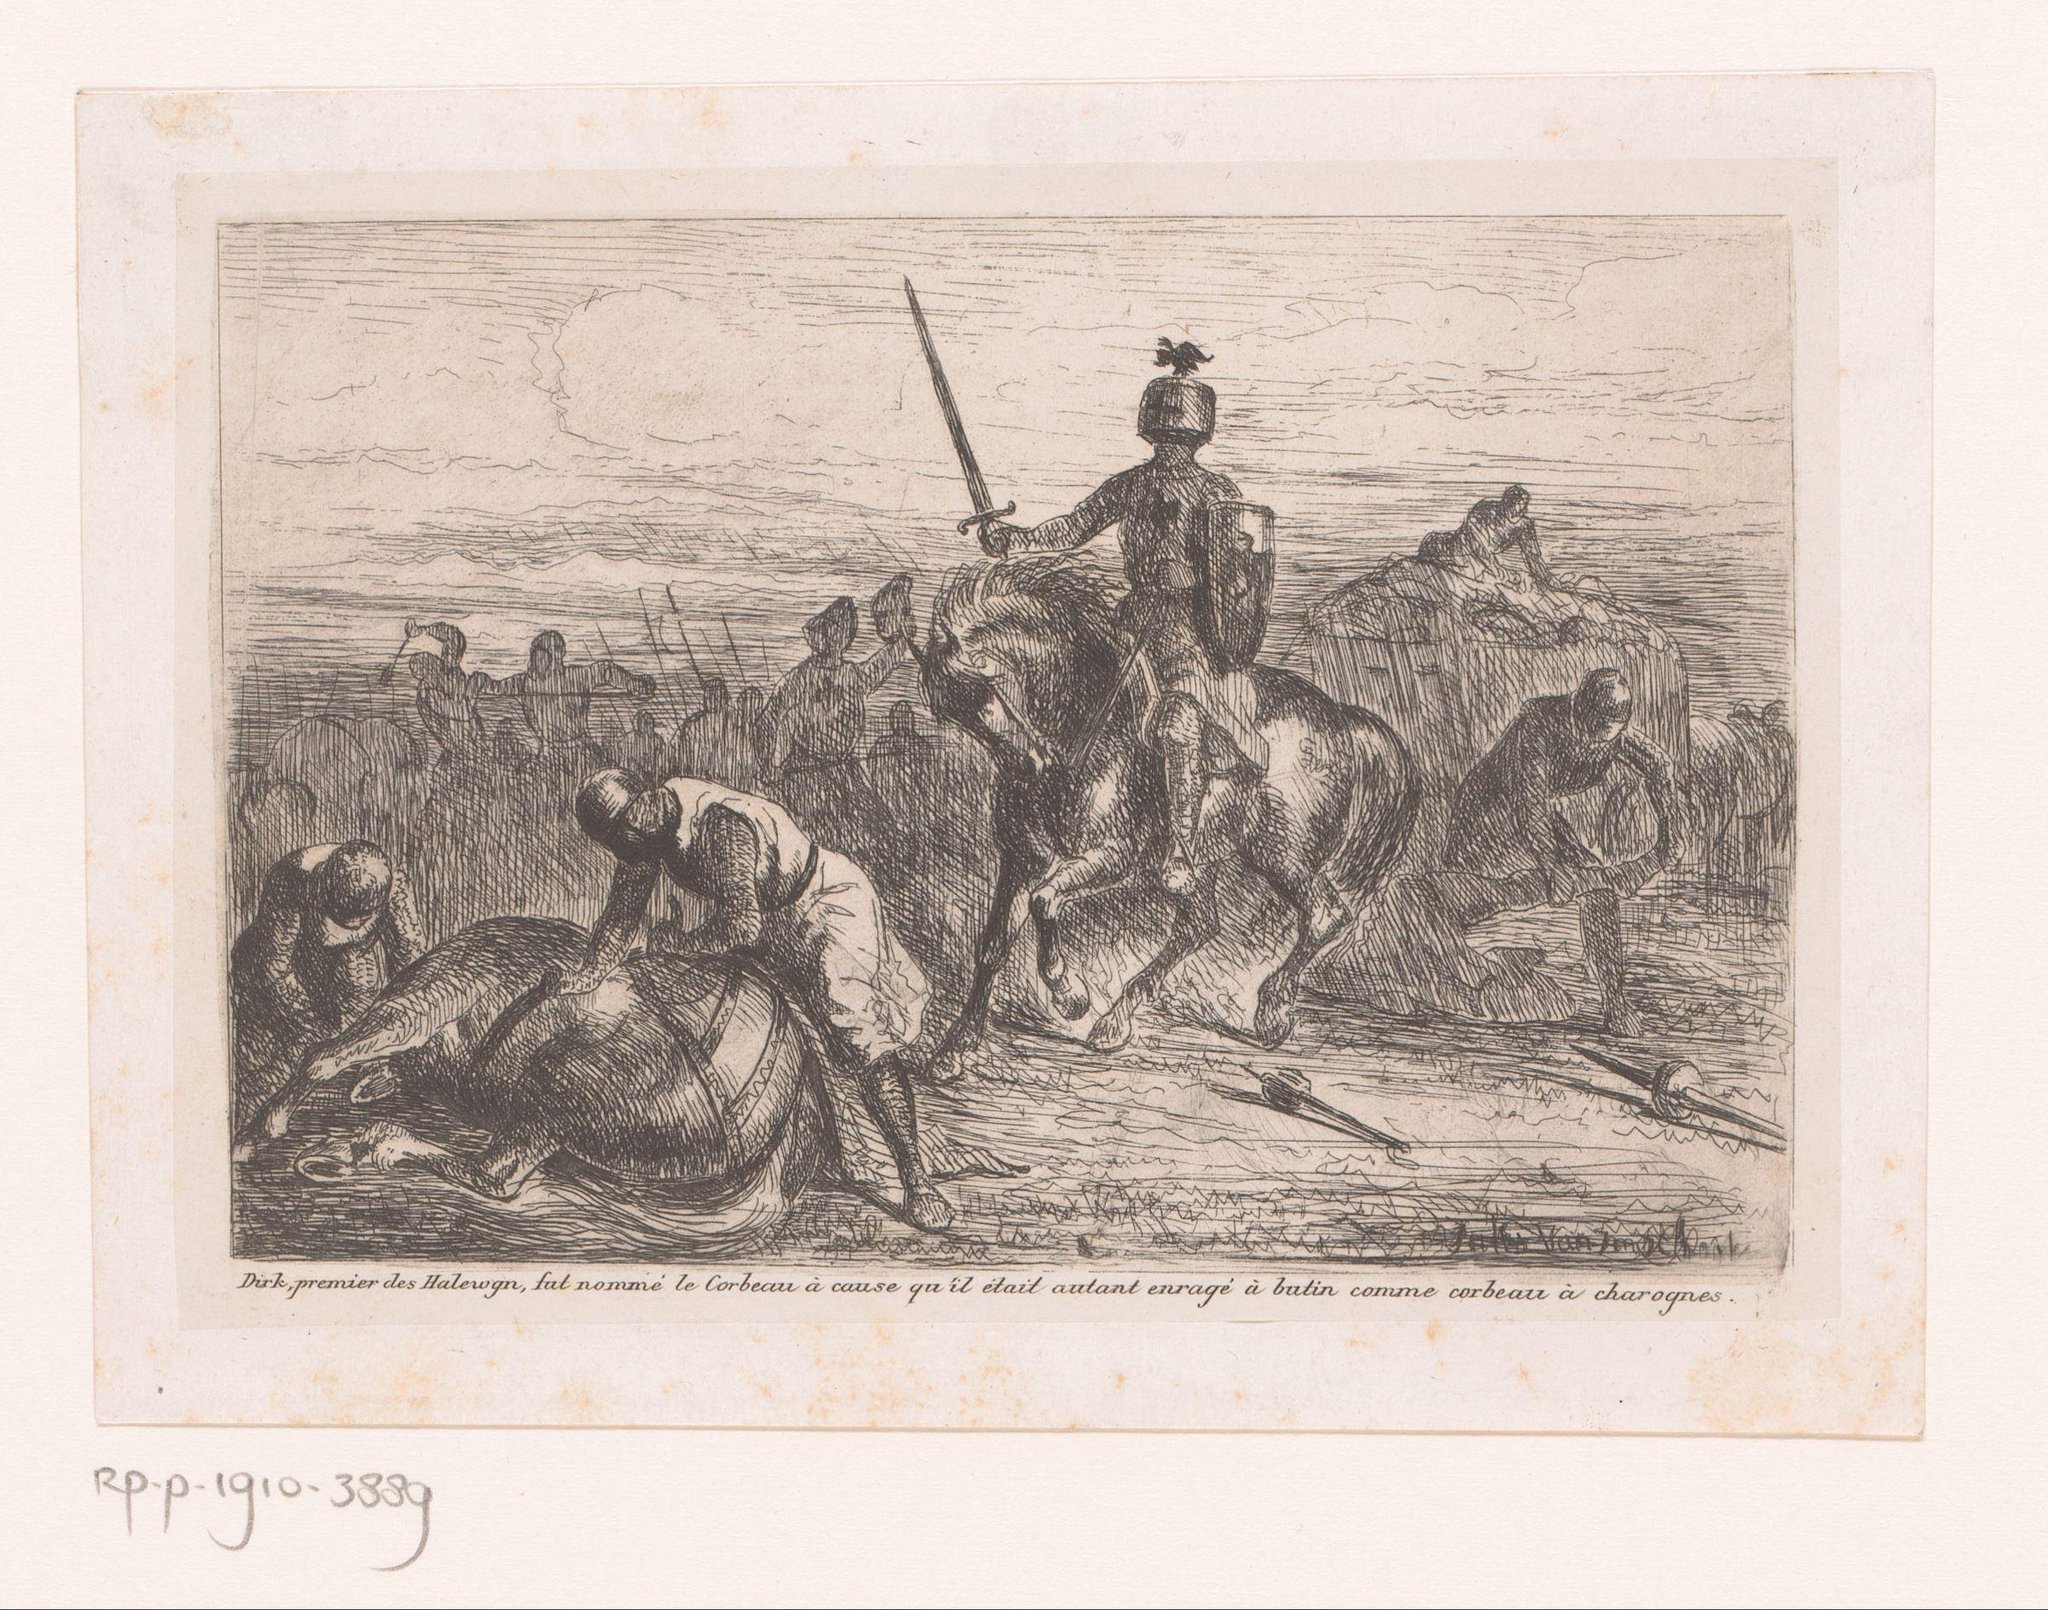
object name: print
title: Dirk, premier des Halewijn, fut nommé le Corbeau à cause qu'il était autant enragé à butin comme corbeau à charognes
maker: jules van imschoot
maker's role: print maker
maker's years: 1821-1884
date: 1831-1884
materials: paper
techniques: etching, intaglio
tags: battle, knight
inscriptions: collector's mark: Lugt 1485, collector's mark: Lugt 2228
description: De afgebeelde persoon wordt in de titel geïdentificeerd als Dirk, eerste van Halewijn. Deze werd de Raaf genoemd.